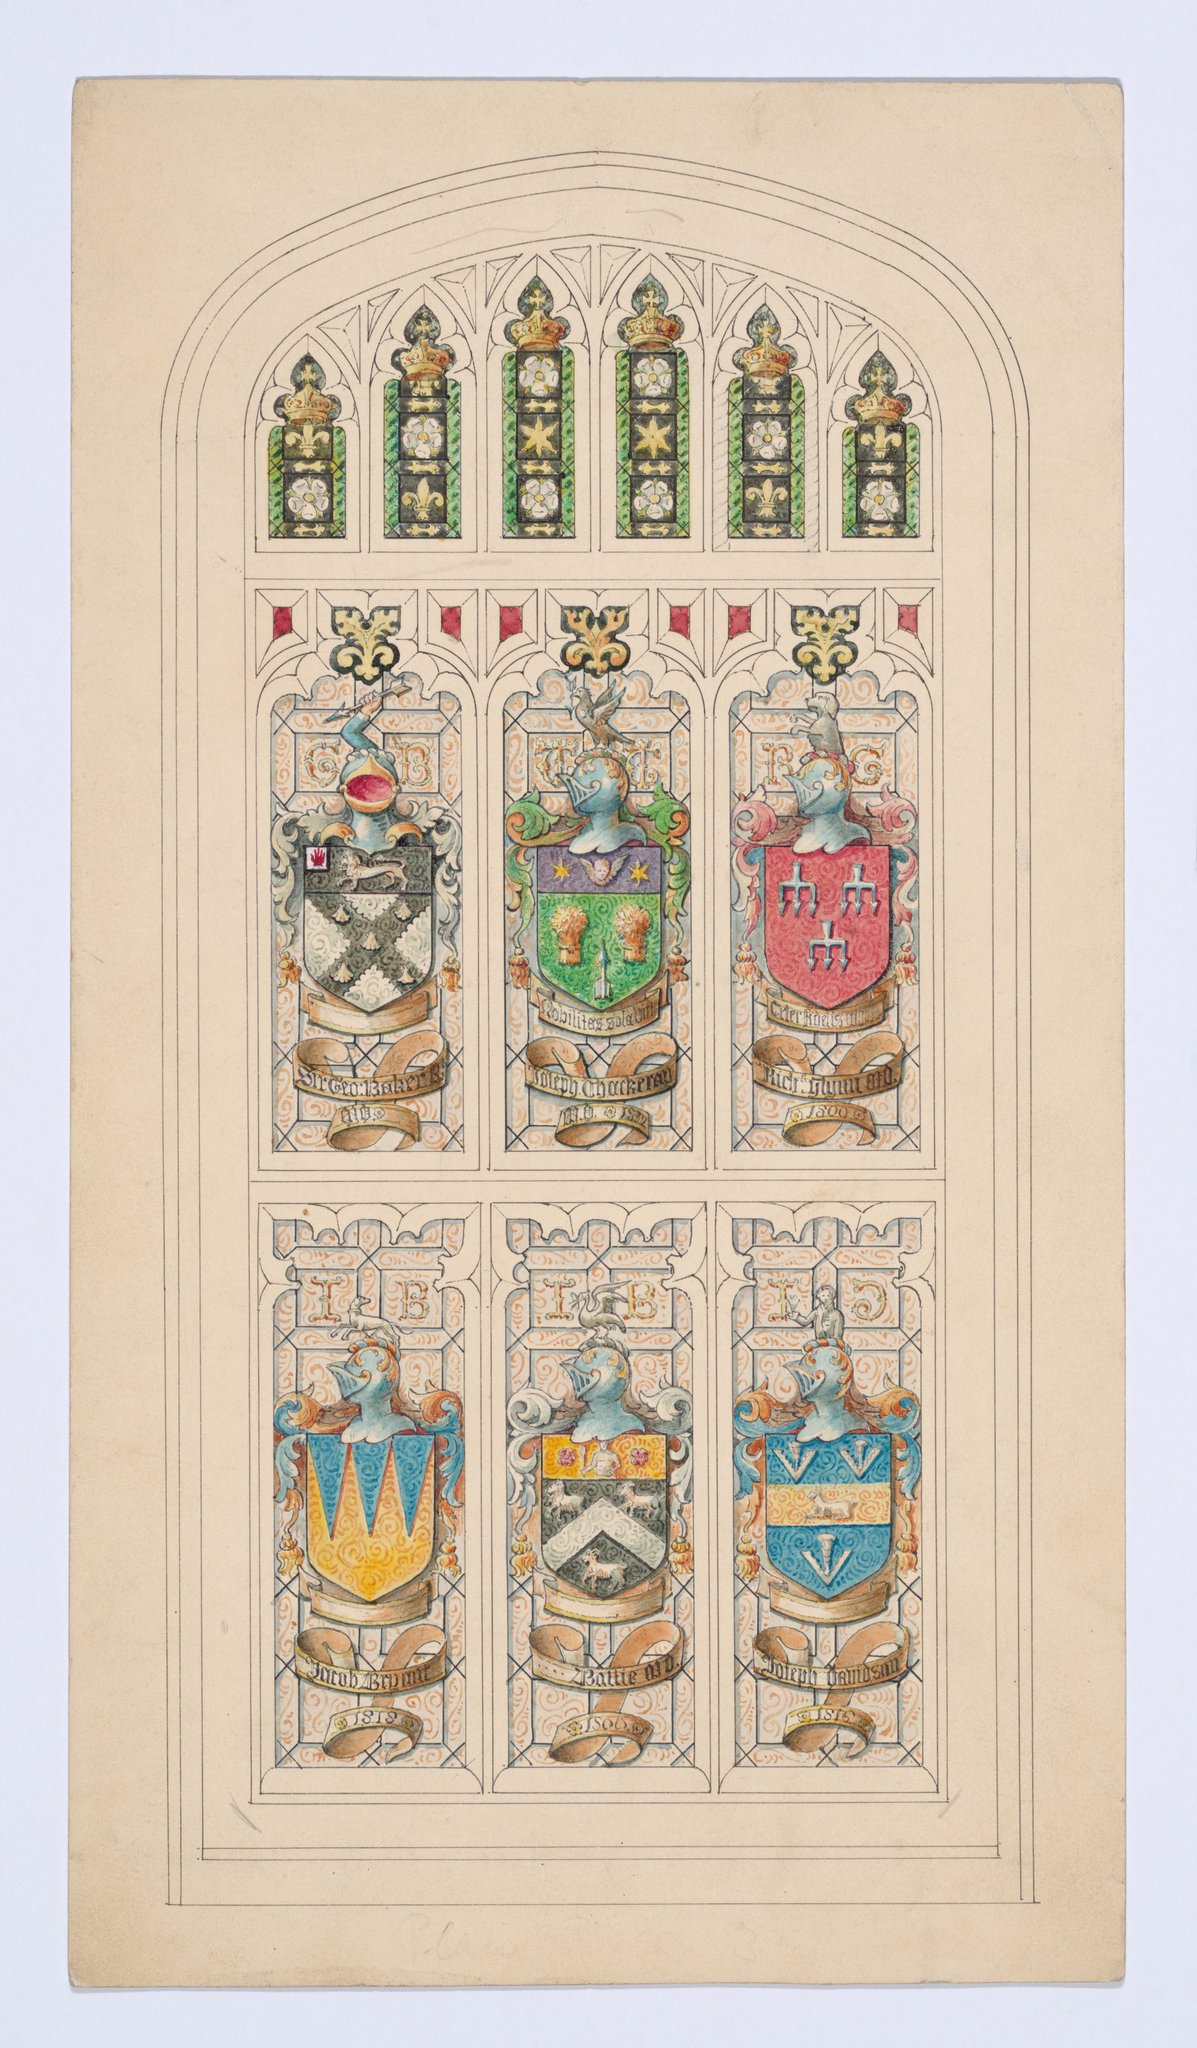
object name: drawing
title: Design for an armorial stained glass window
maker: anonymous, british, 19th century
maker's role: artist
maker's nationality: british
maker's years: 1800-1900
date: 1832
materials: graphite, ink, watercolor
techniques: pen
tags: coat of arms